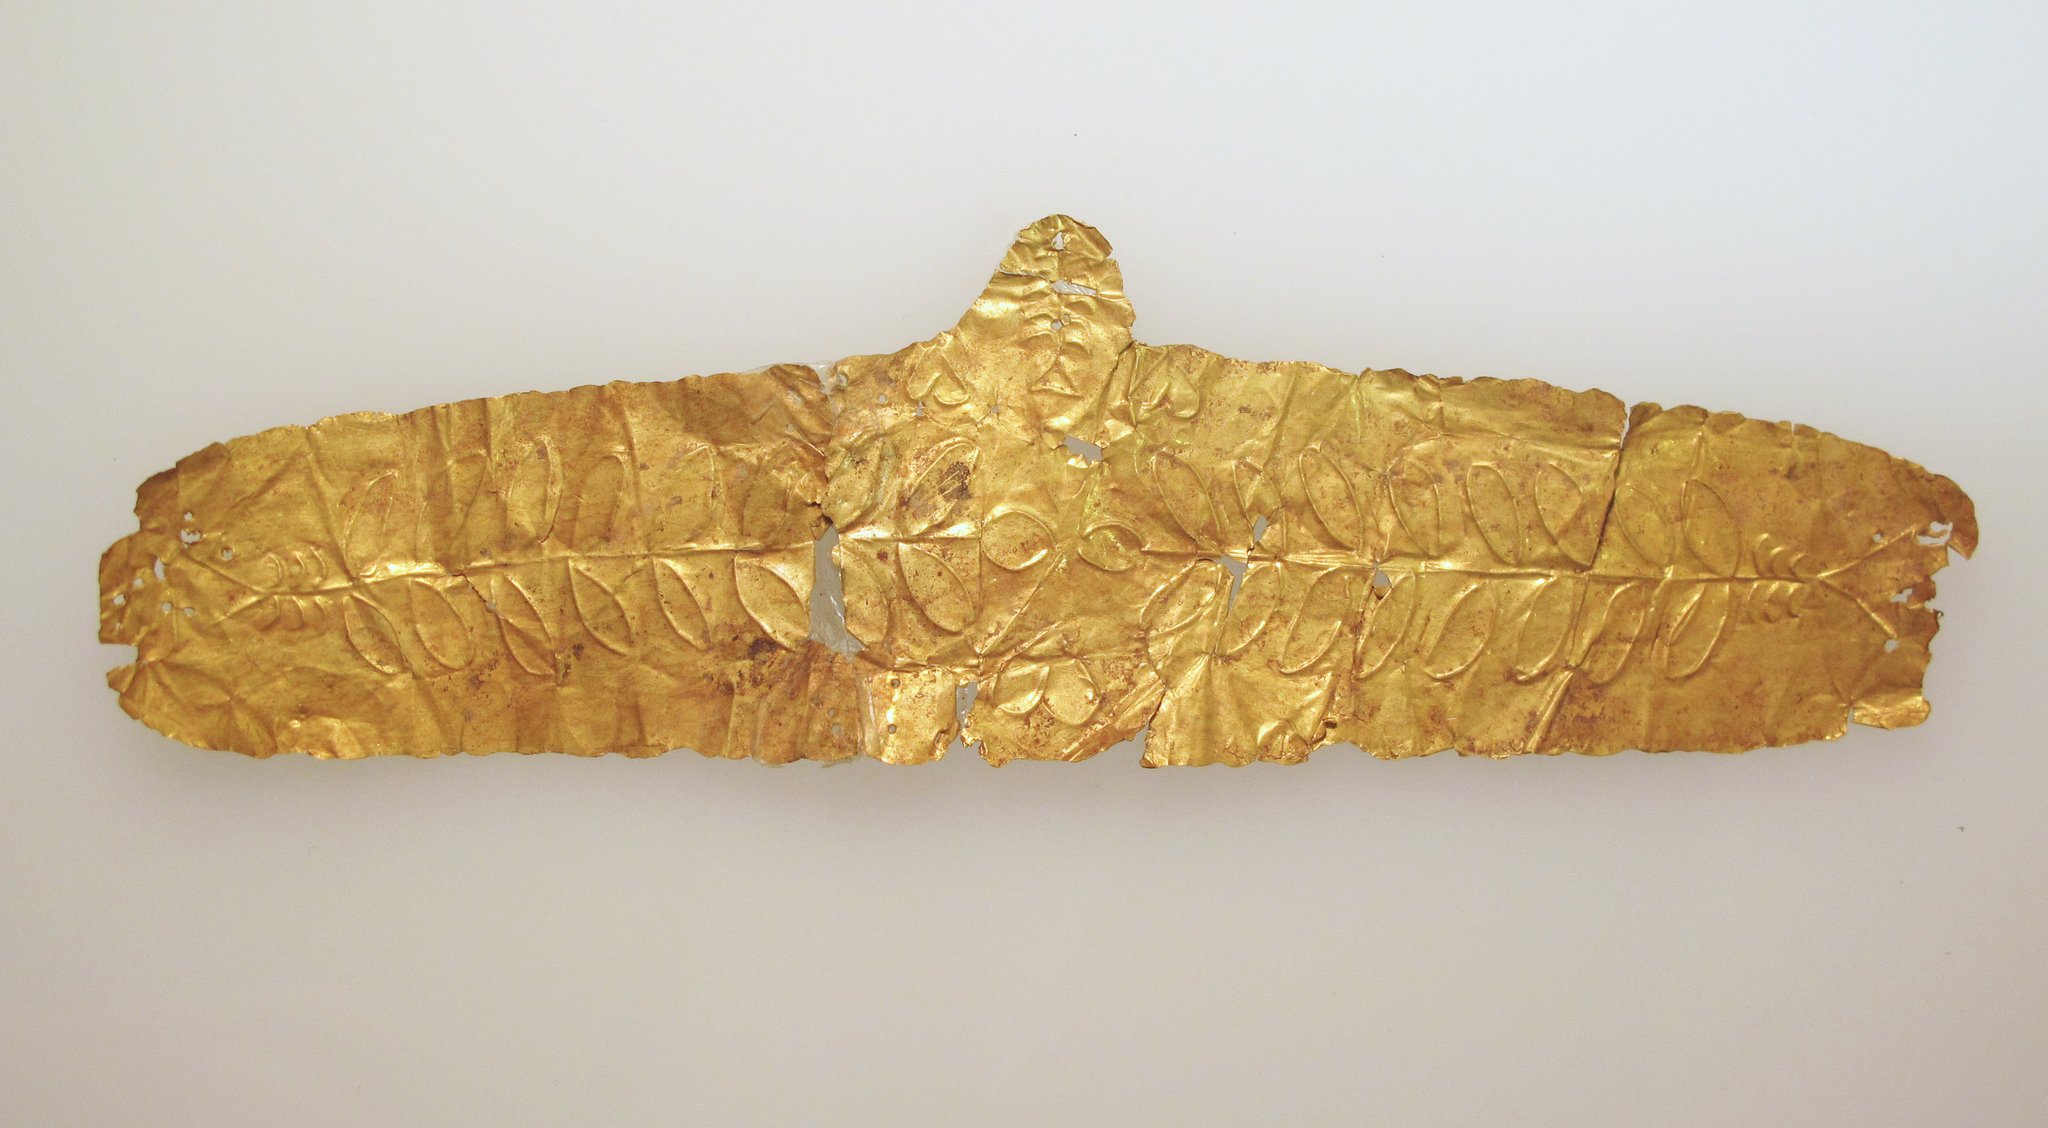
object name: frontlet of gold leaf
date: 7000 BCE-330 CE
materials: gold